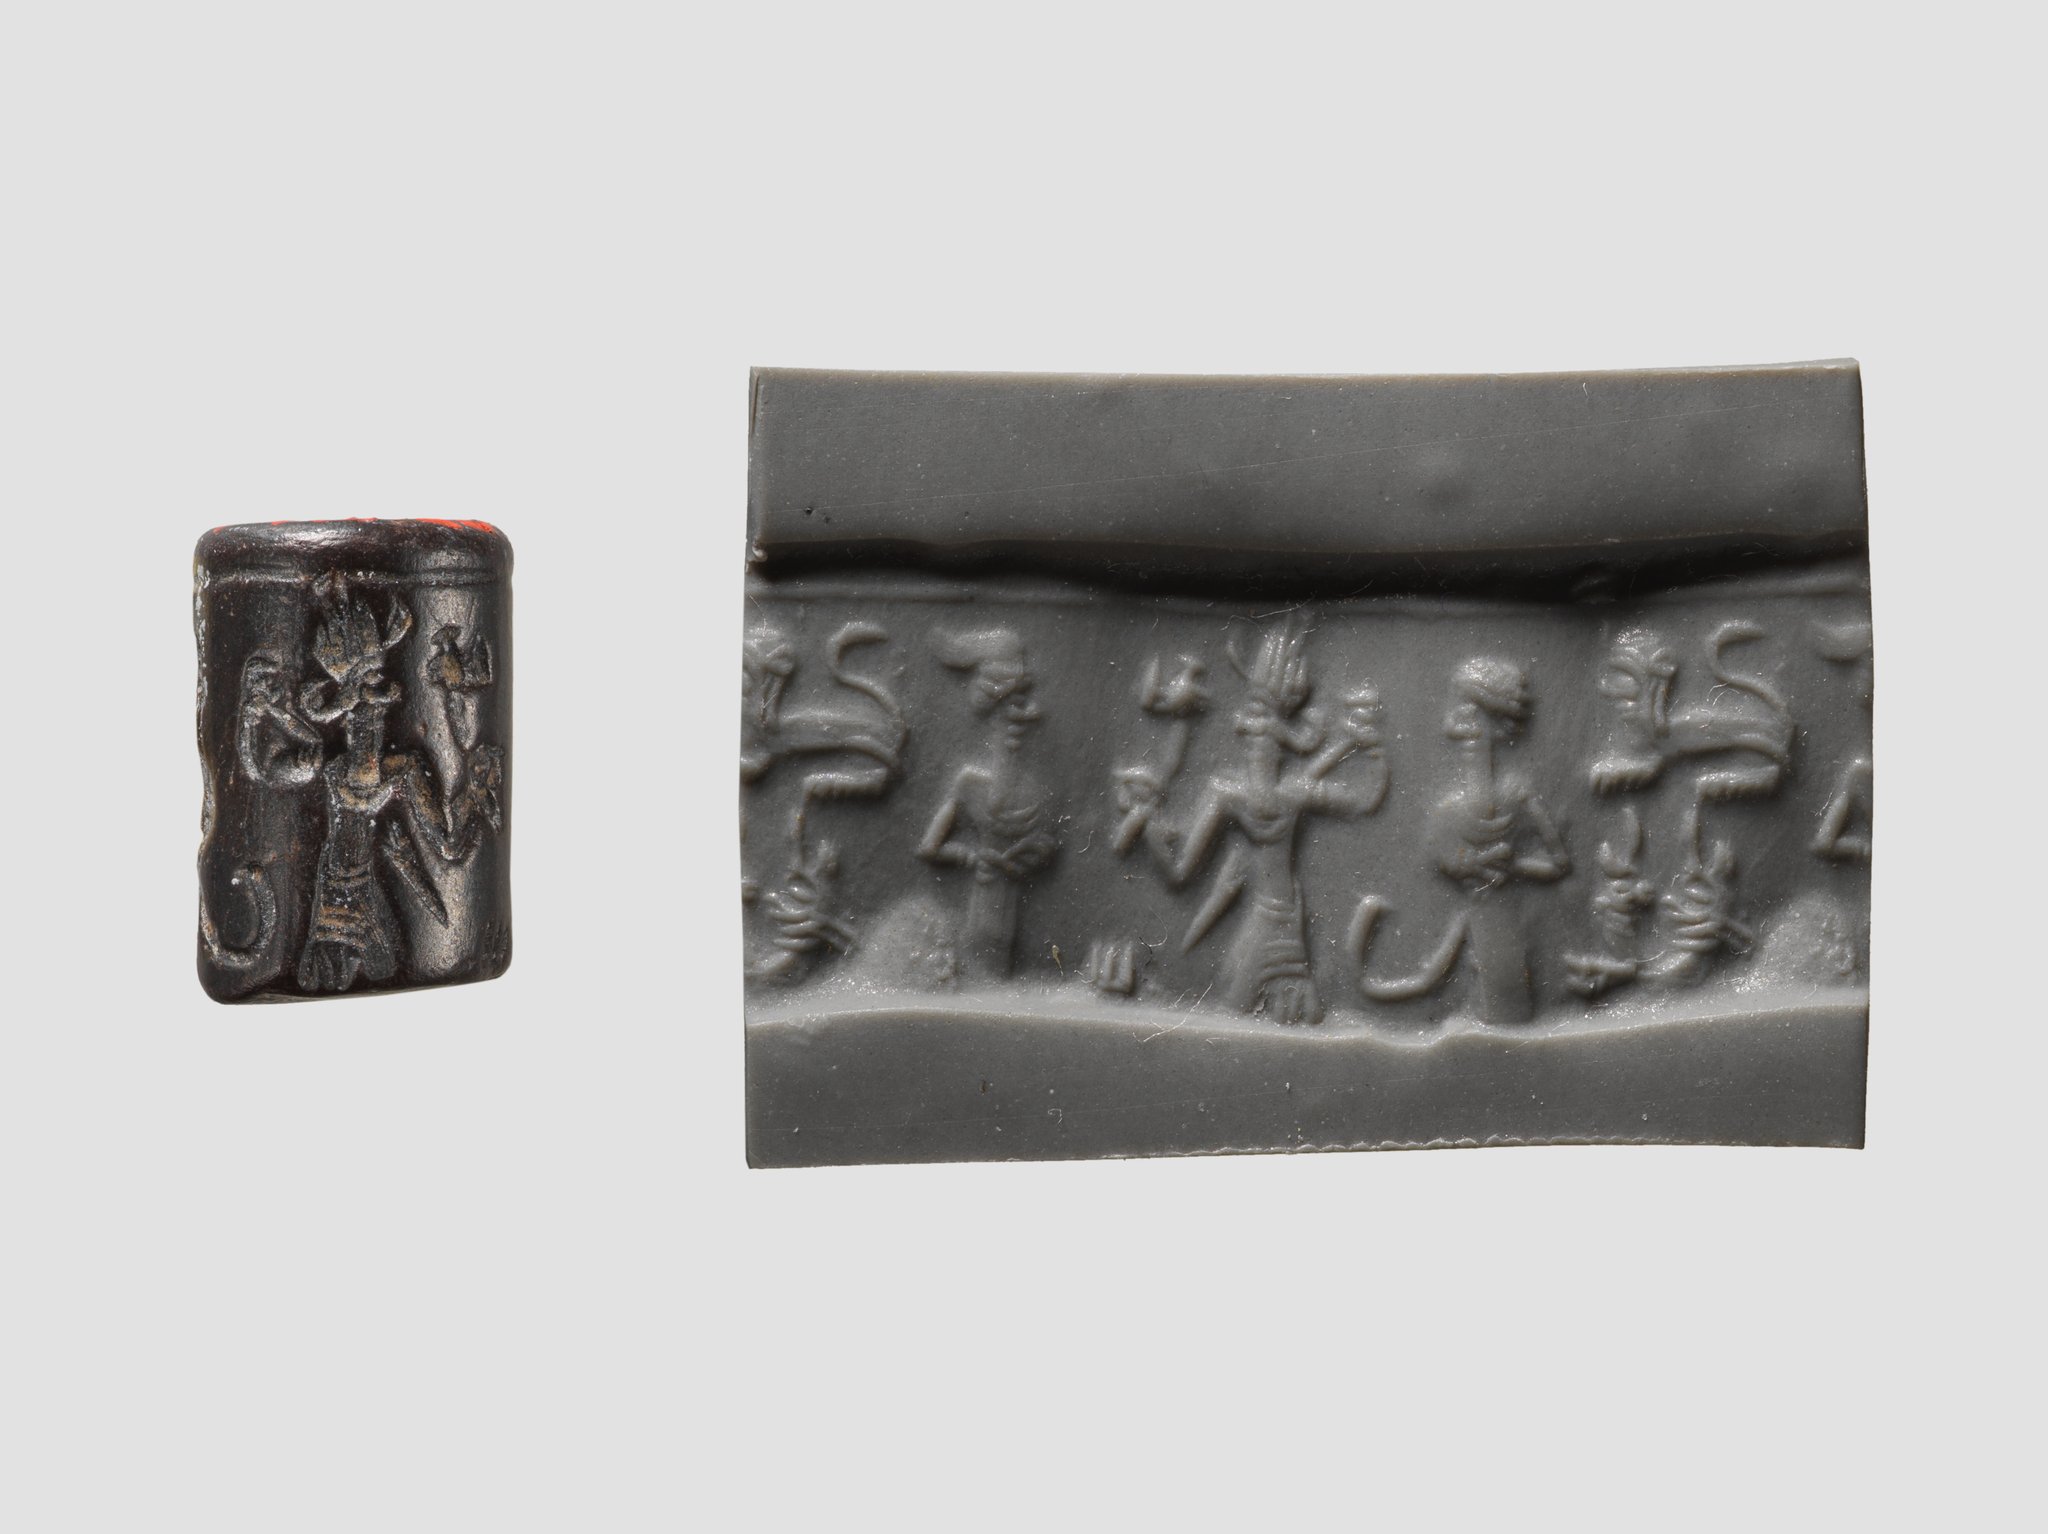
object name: cylinder seal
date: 2000-1668 BCE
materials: mineral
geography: syria